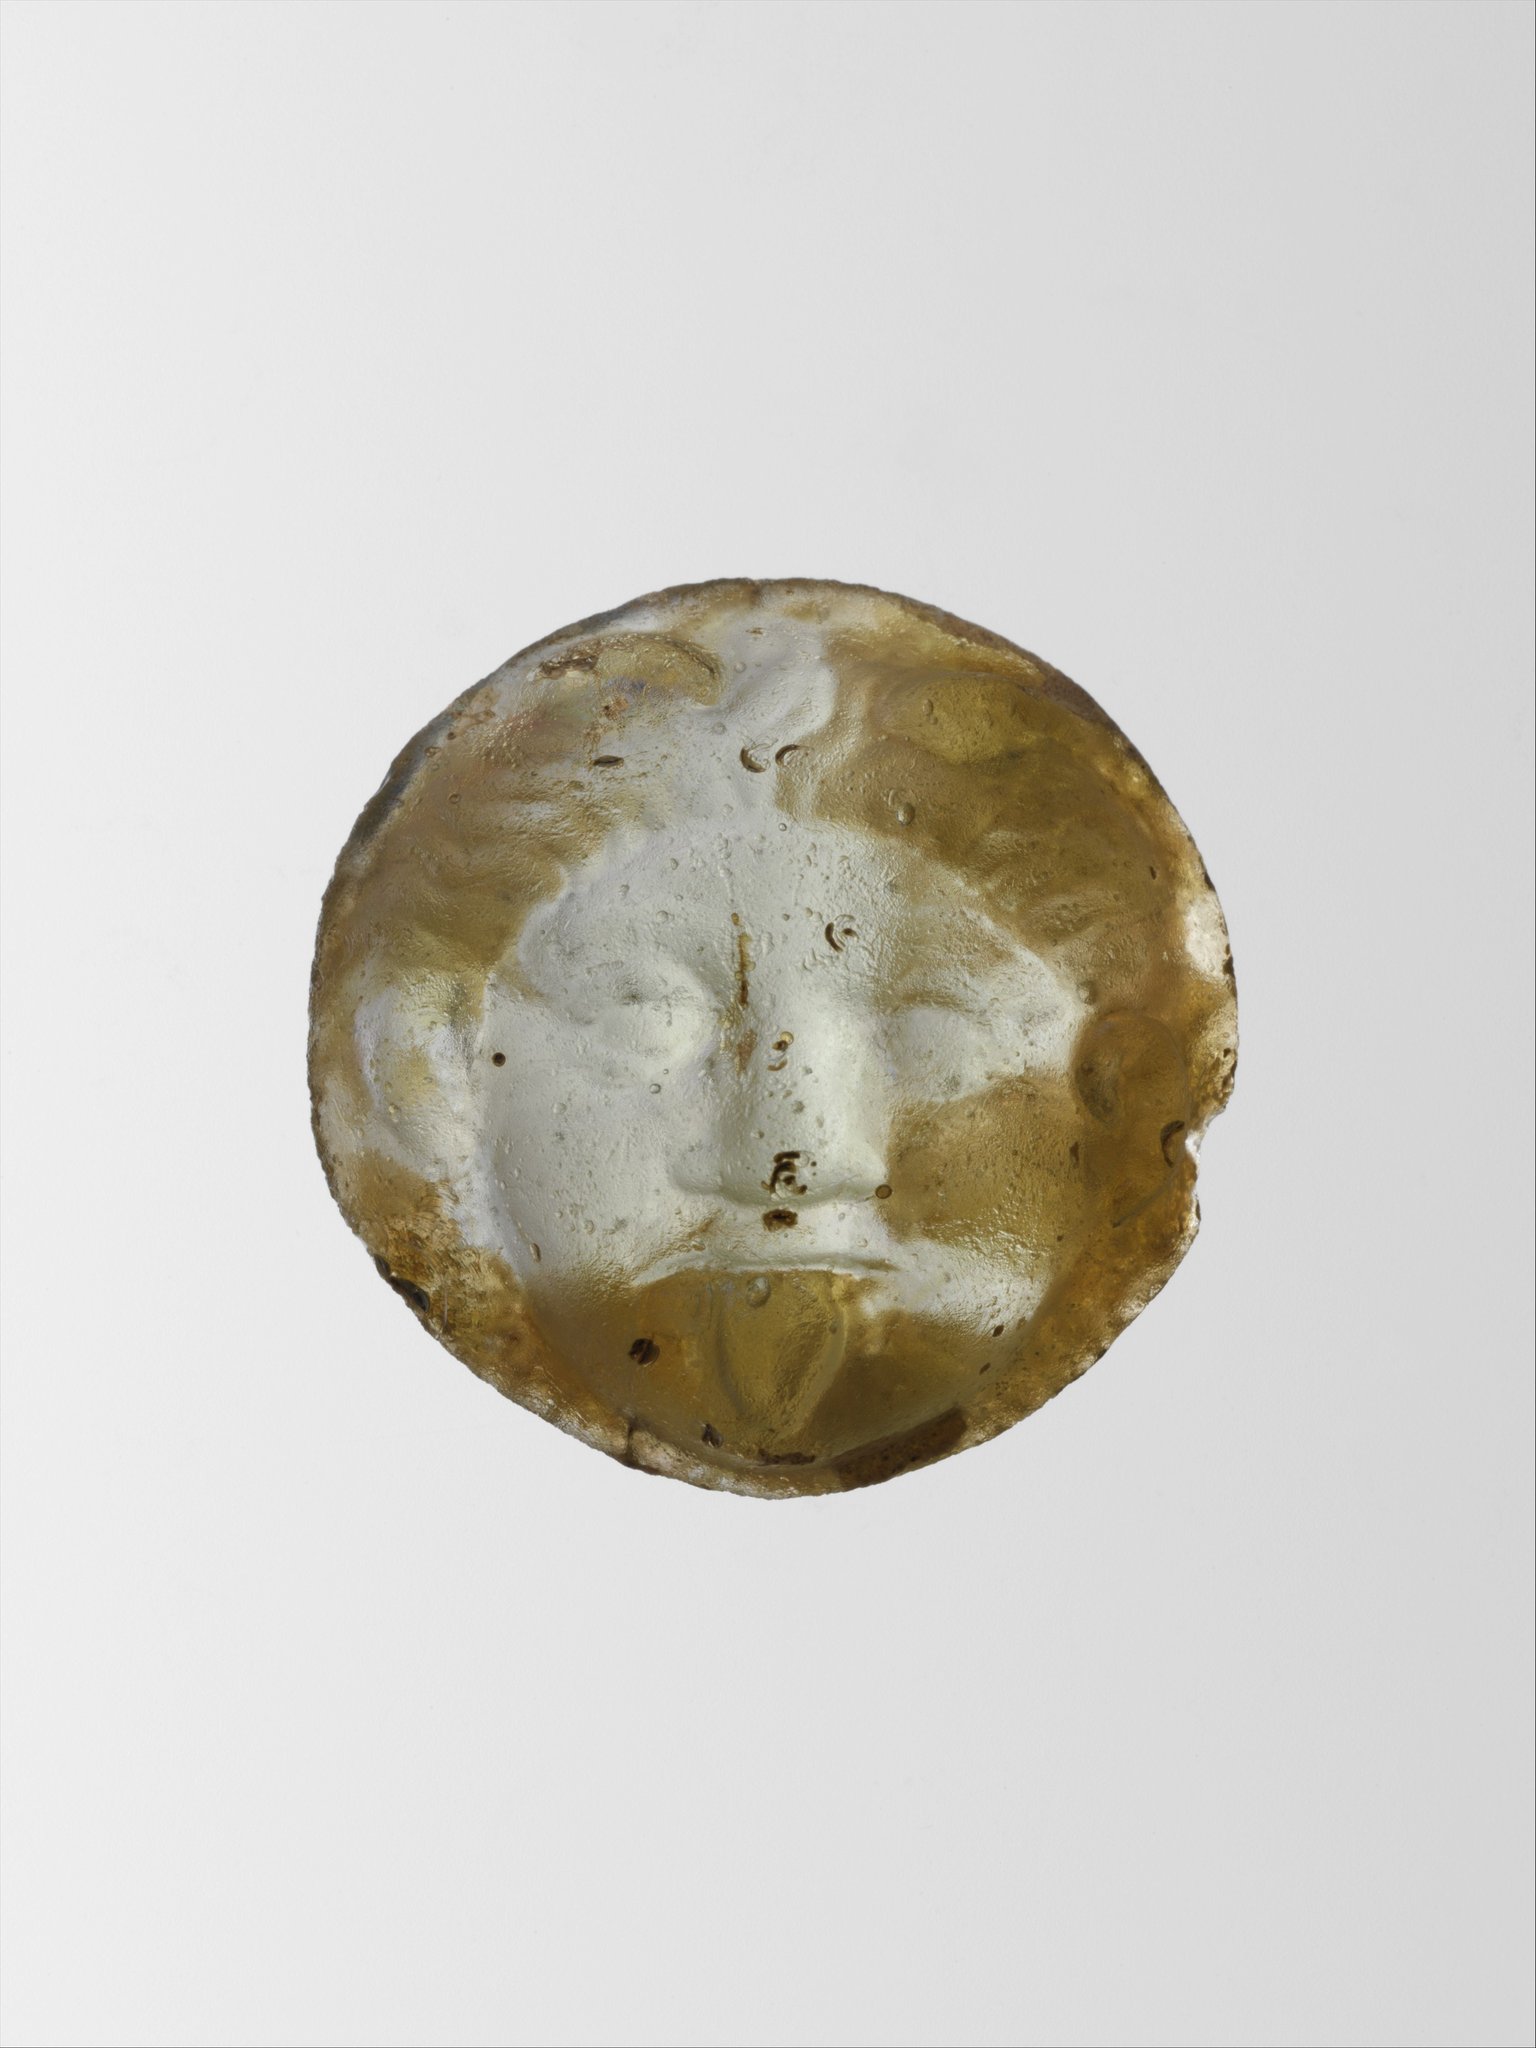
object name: appliqué with medusa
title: Glass appliqué with Medusa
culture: roman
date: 1-200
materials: glass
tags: medusa